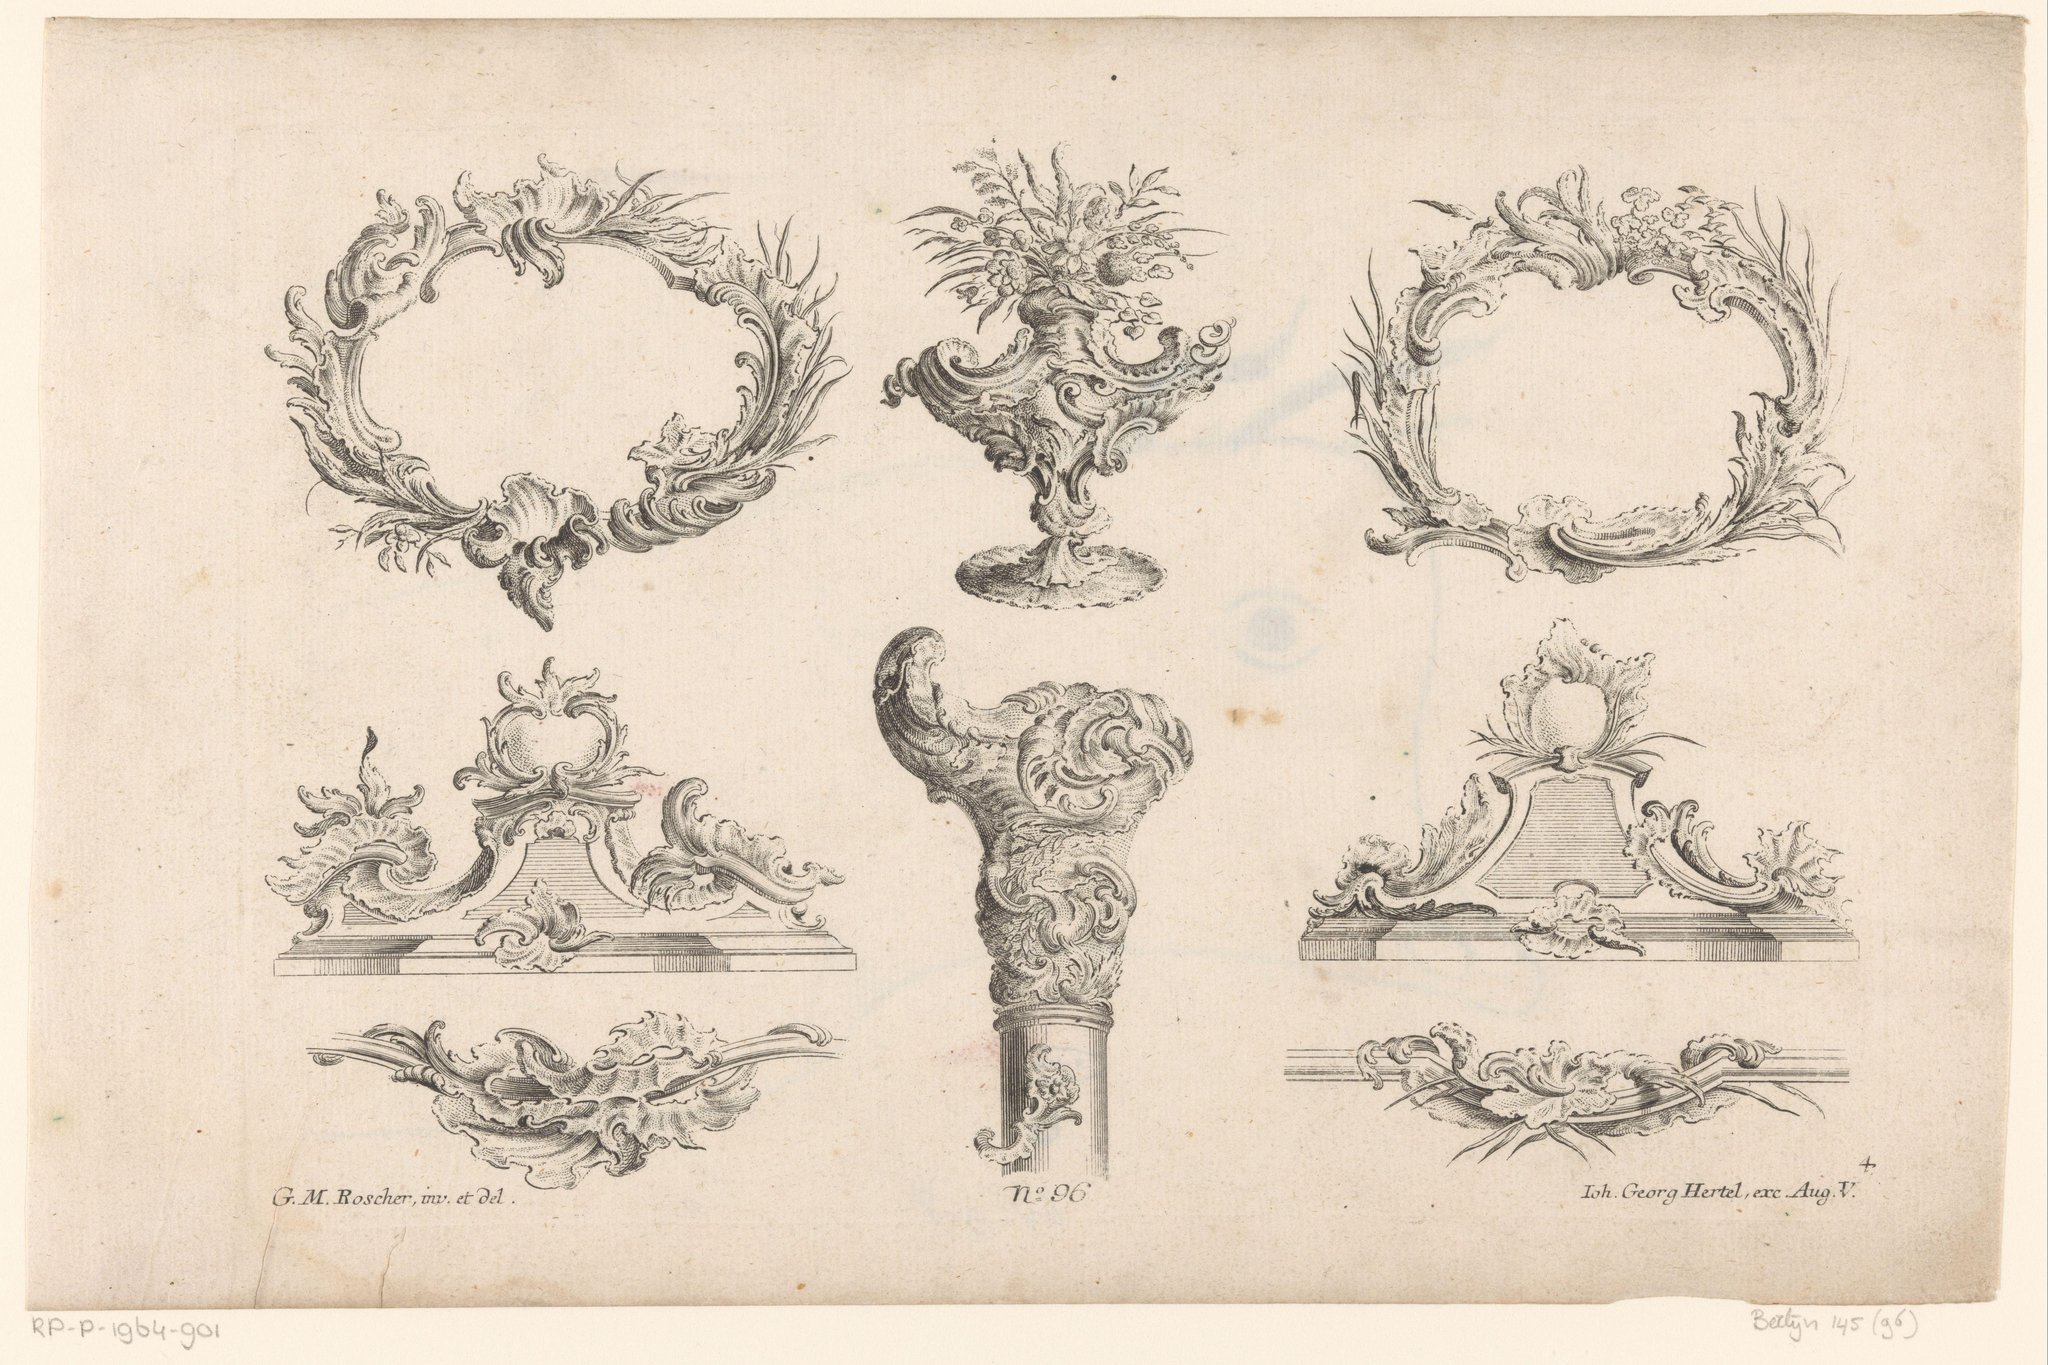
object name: ornament print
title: Rocailles en een vaas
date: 1727-1775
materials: paper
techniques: etching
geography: augsburg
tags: rocaille ornament, vase ~ ornament, ornament ~ cartouche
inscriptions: collector's mark: Lugt 2228, collector's mark: Lugt 2760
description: Rocaille ornamenten, cartouches, een geornamenteerde vaas met bloemen en een stokknop. Uitgeversnummer 96.